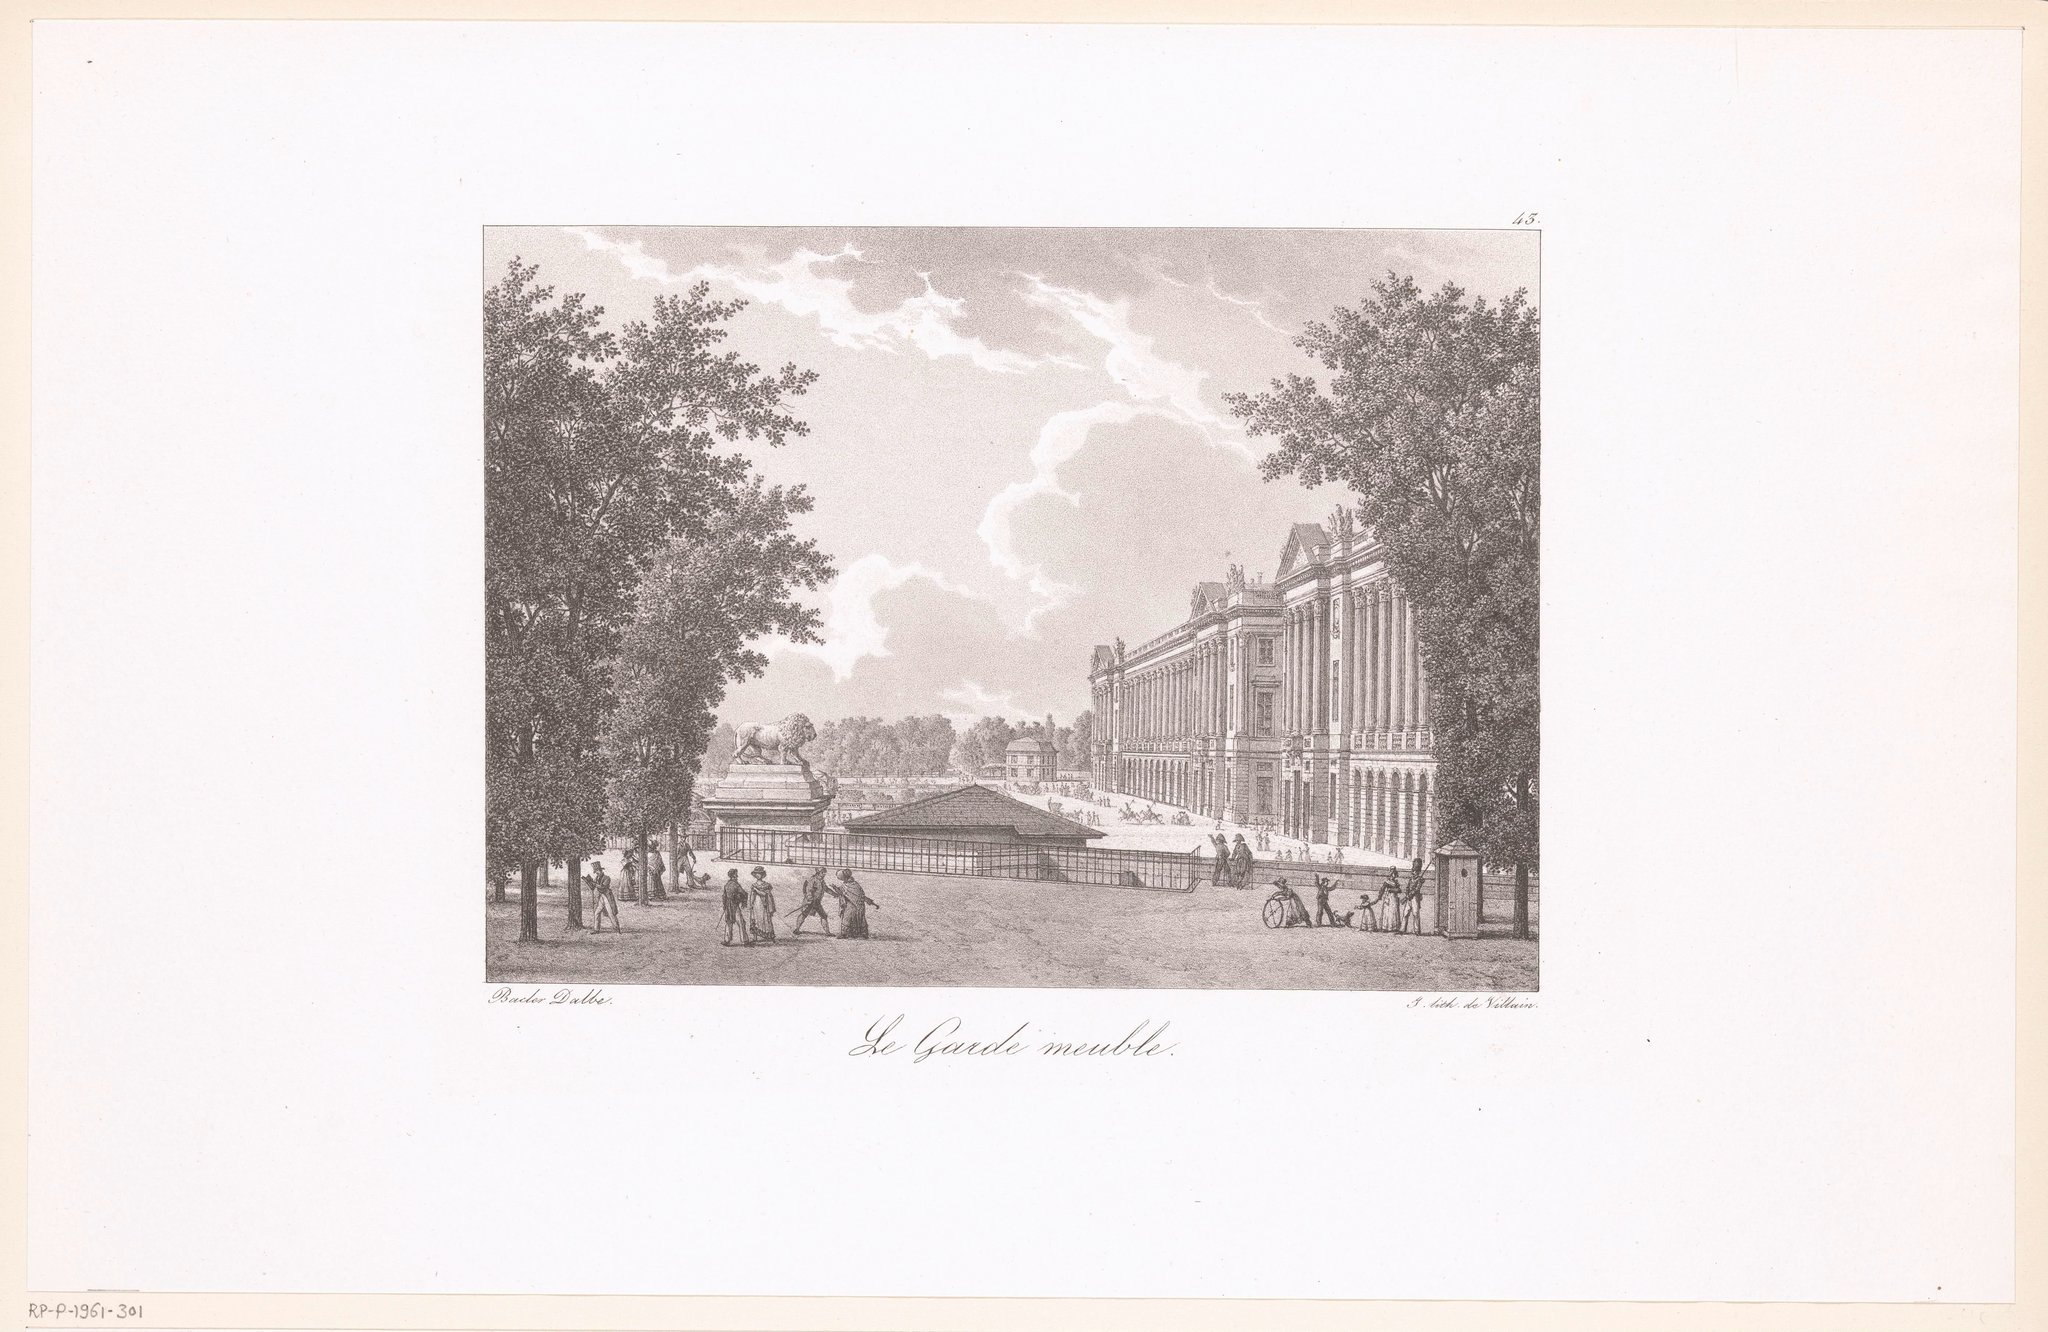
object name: print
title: Le Garde Meuble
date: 1822-1824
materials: paper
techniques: lithograph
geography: paris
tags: hôtel, i.e. small palace in city, village square, place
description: Het Hôtel du Garde-Meuble heet tegenwoordig Hôtel de la Marine.